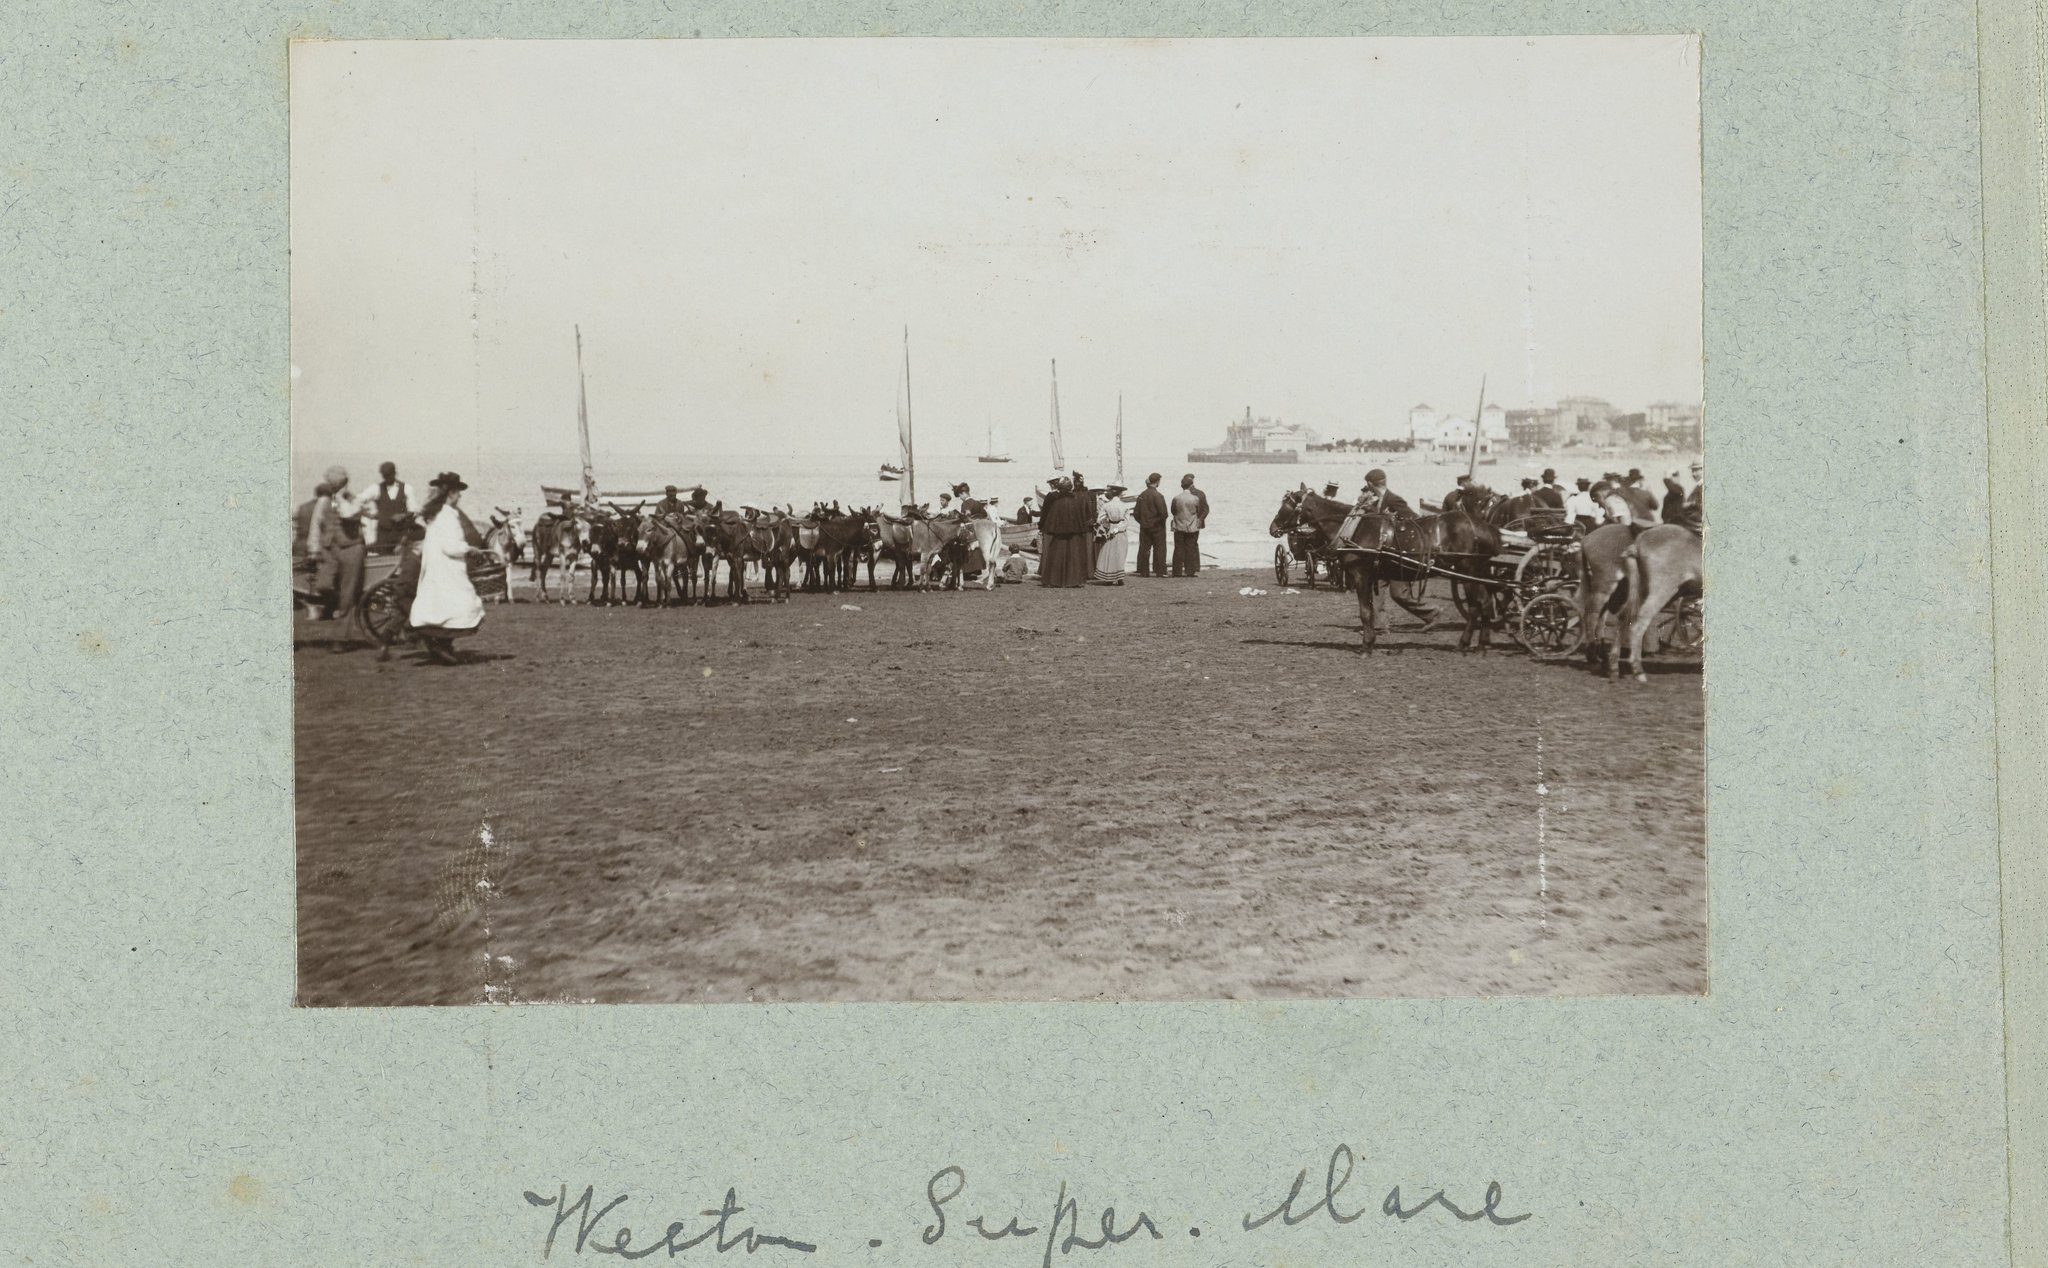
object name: photograph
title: Strand met ezels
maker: frits freerks fontein fz.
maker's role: fotograaf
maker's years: 1882-1928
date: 1901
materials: cardboard, paper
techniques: gelatin silver print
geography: netherlands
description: Weston-Super-Mare is een badplaats in Groot-Brittannië. Foto uit album 'Photographieën".